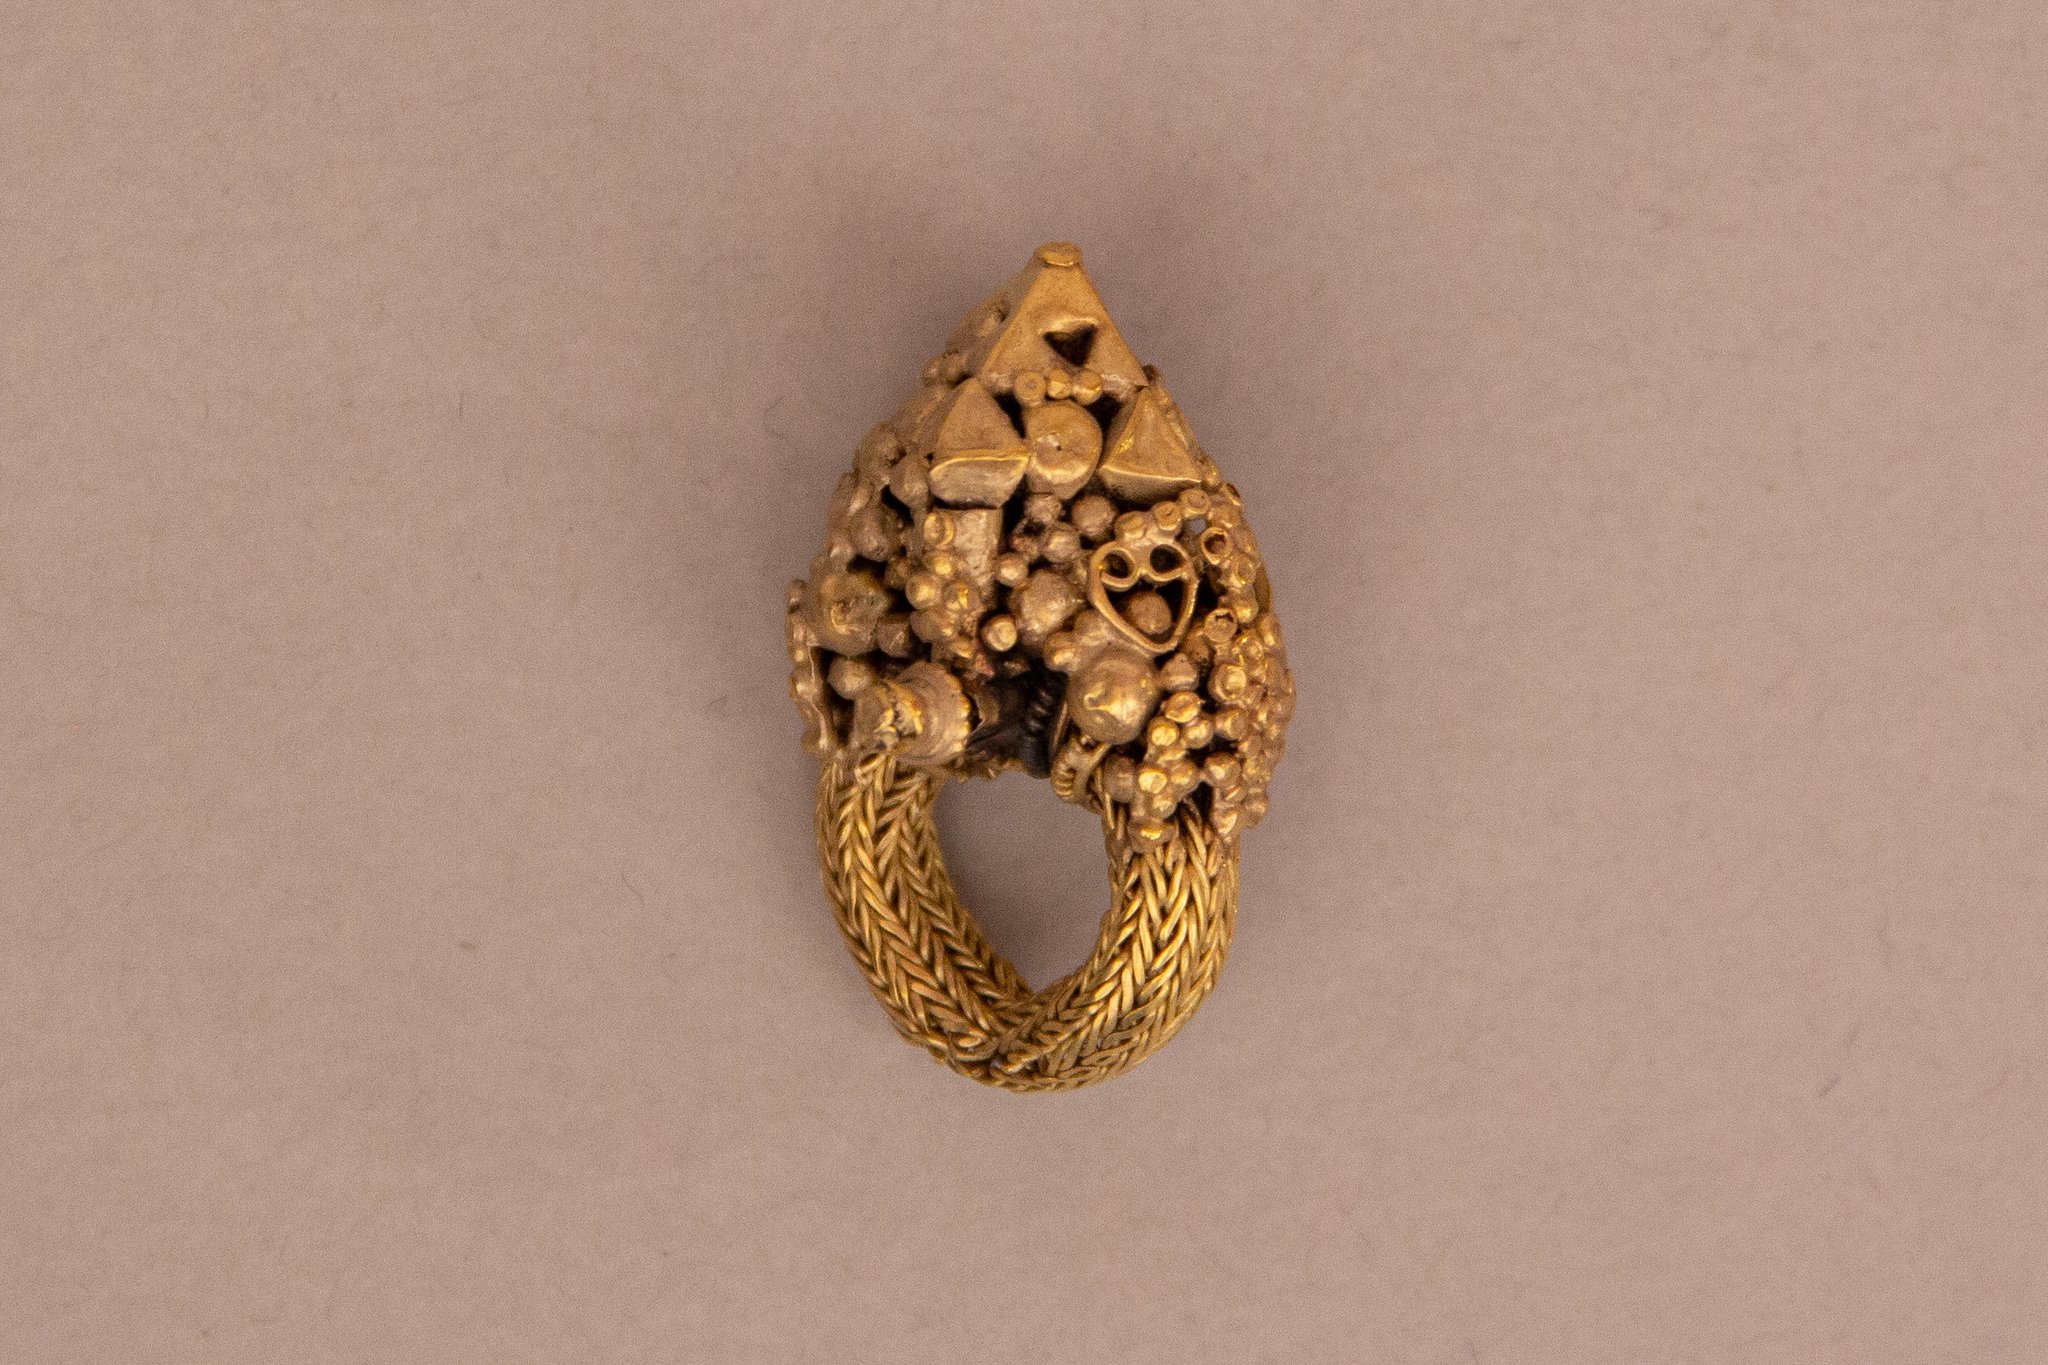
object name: ring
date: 1701-1900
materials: gold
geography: india